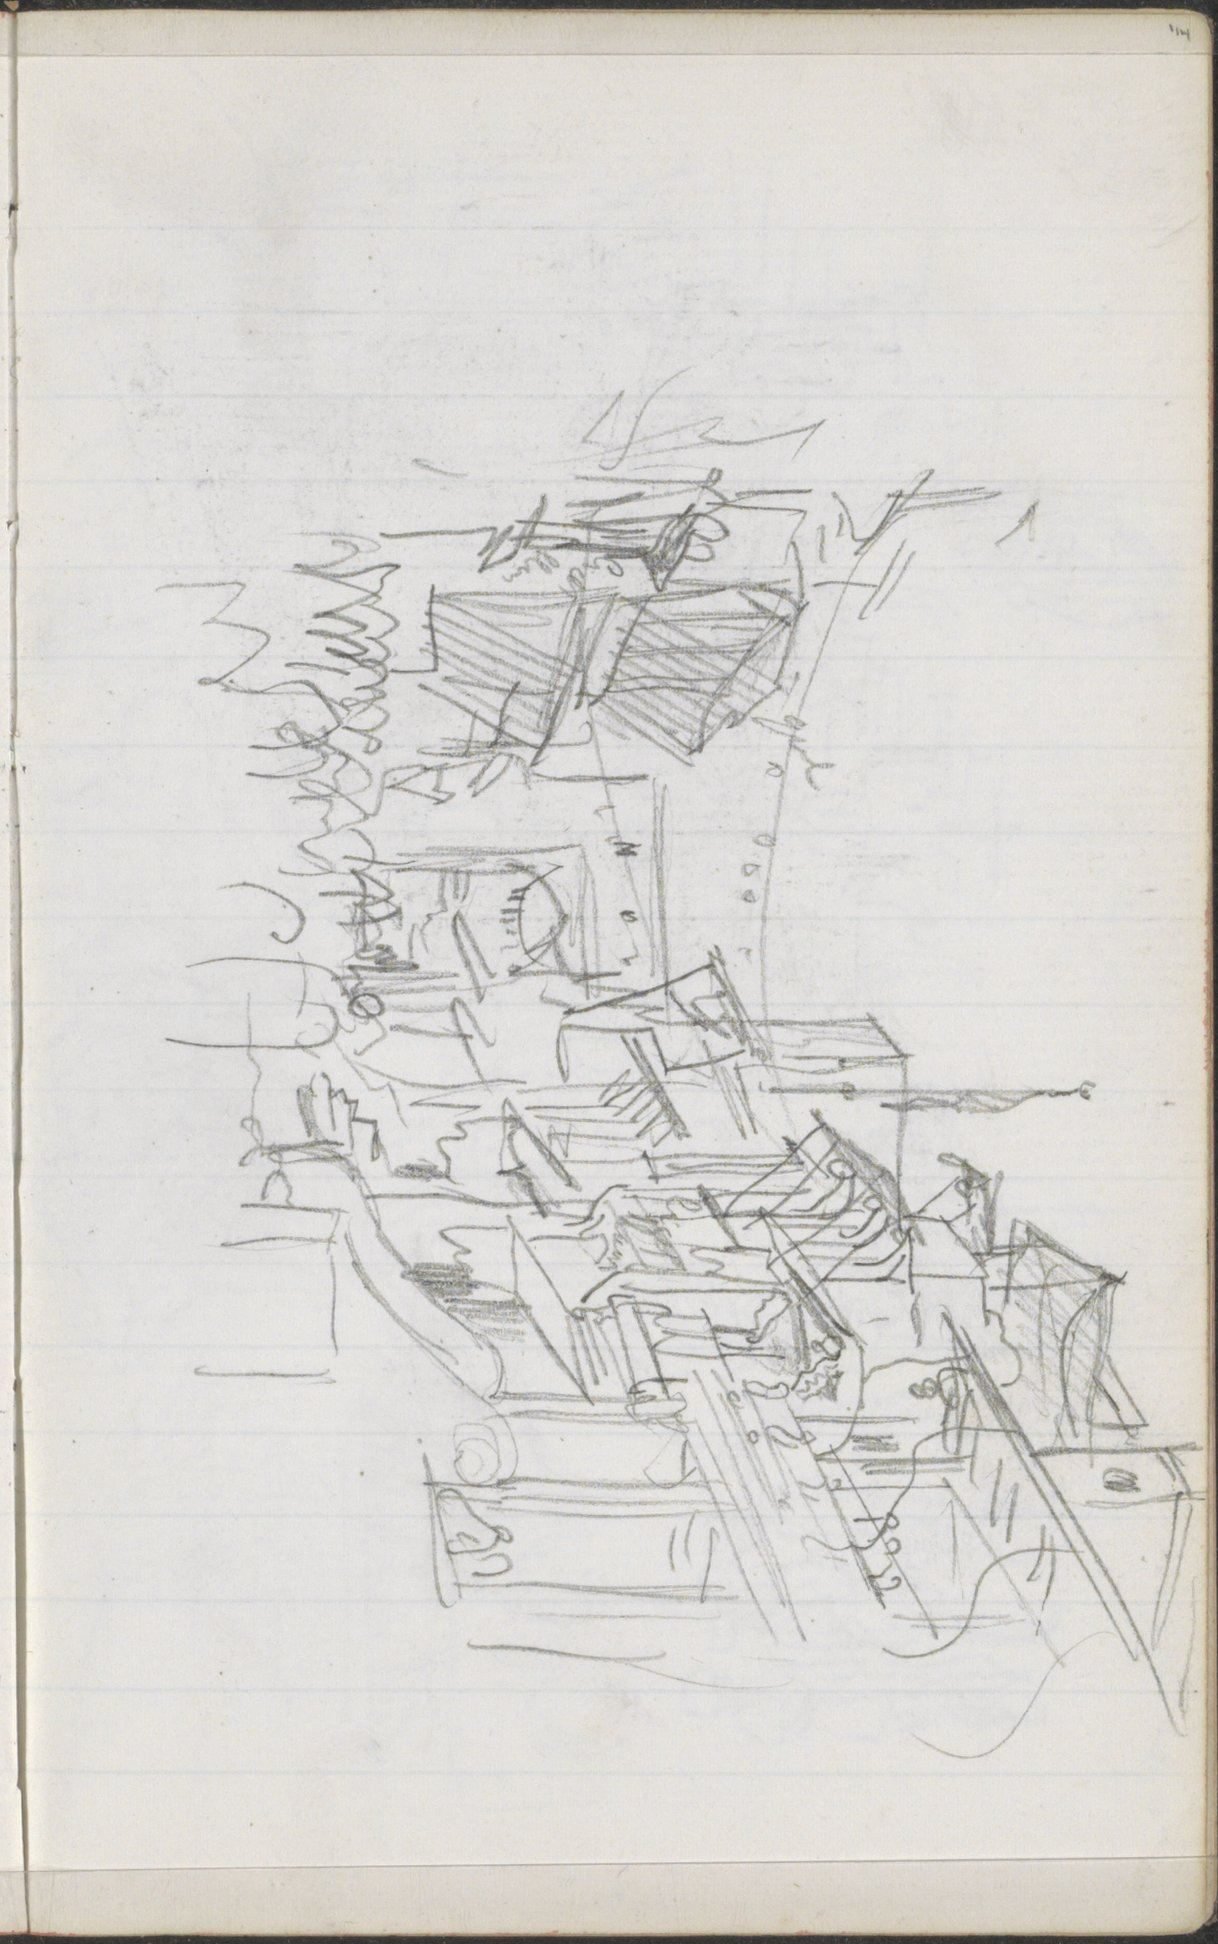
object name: sketchbook leaf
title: Straat met een poort in India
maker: marius bauer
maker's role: draughtsman, print maker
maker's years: 1867-1932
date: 1897-1898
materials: pencil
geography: india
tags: arch, archivolt ~ architecture, street lighting, street (+ city(-scape) with figures, staffage)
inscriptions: kleurnotitie, handgeschreven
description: Over de straat zijn slingers met lampen gespannen. Pagina 114 uit een schetsboek met 62 bladen.